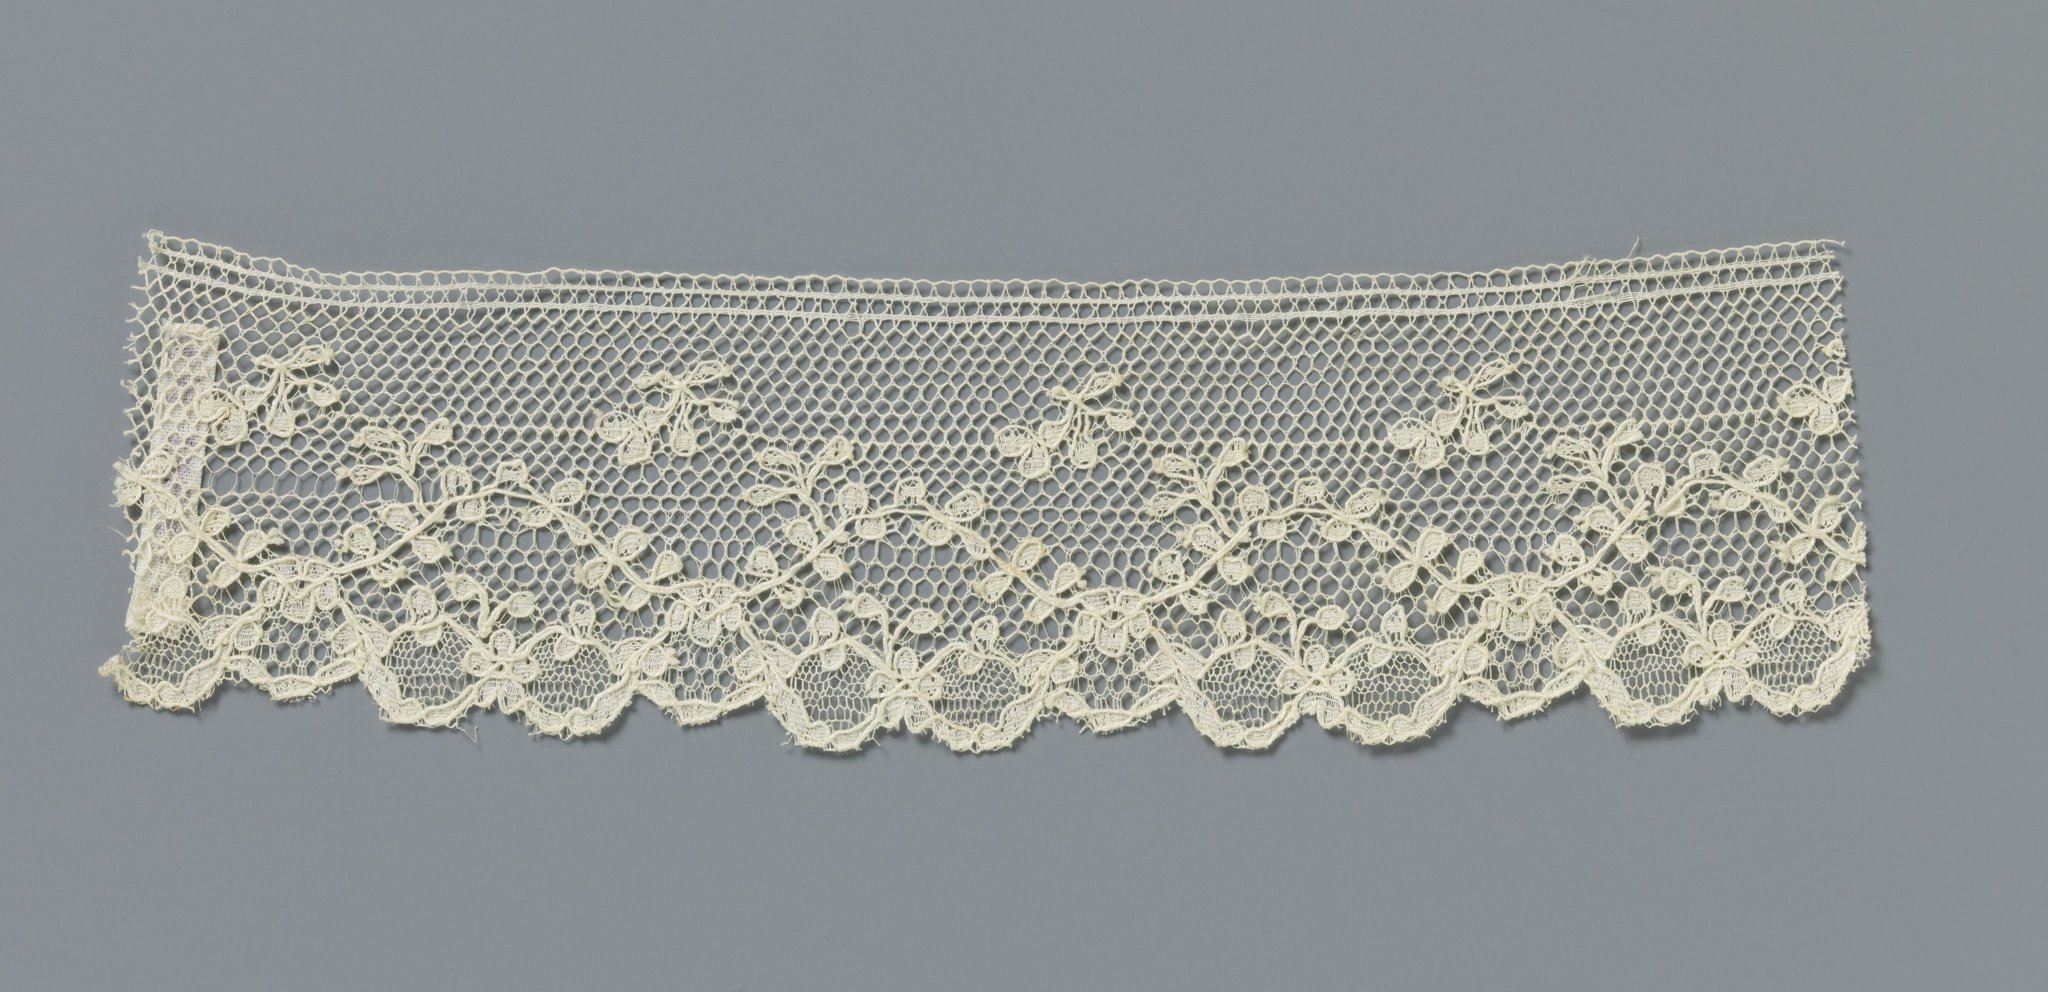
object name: strip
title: Strook machinale kant met regelmatig golvende rank met kleine blaadjes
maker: Anonymous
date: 1880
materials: cotton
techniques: lace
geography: europe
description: Strook naturelkleurige machinale kant: machinale Argentan-kant. Het patroon bestaat uit een regelmatig golvende rank met kleine blaadjes. Boven elk golfdal hangt een los takje. Langs de onderzijde bestaat het patroon uit twee golvende ranken met kleine blaadjes die samen een aaneenschakeling vormen van cirkelvormige cartouches en tegelijkertijd de schulpenrand. Elke derde cartouche raakt de regelmatige golflijn daarboven, waarbij het raakpunt wordt oversneden door een rozetbloempje. De motieven zijn voorzien van contourdraden en in de cartouches zijn siergronden toegepast. De motieven zijn met elkaar verbonden door een machinale Argentan-grond, met mazen die door de machine lijken te zijn gefestoneerd zoals dat bij de handgemaakte Argentan-kant wordt gedaan. De bovenzijde van de strook is recht afgewerkt. De schulpenrand lijkt door de loshangende draadjes uit de machinale siergronden afgewerkt met picots.